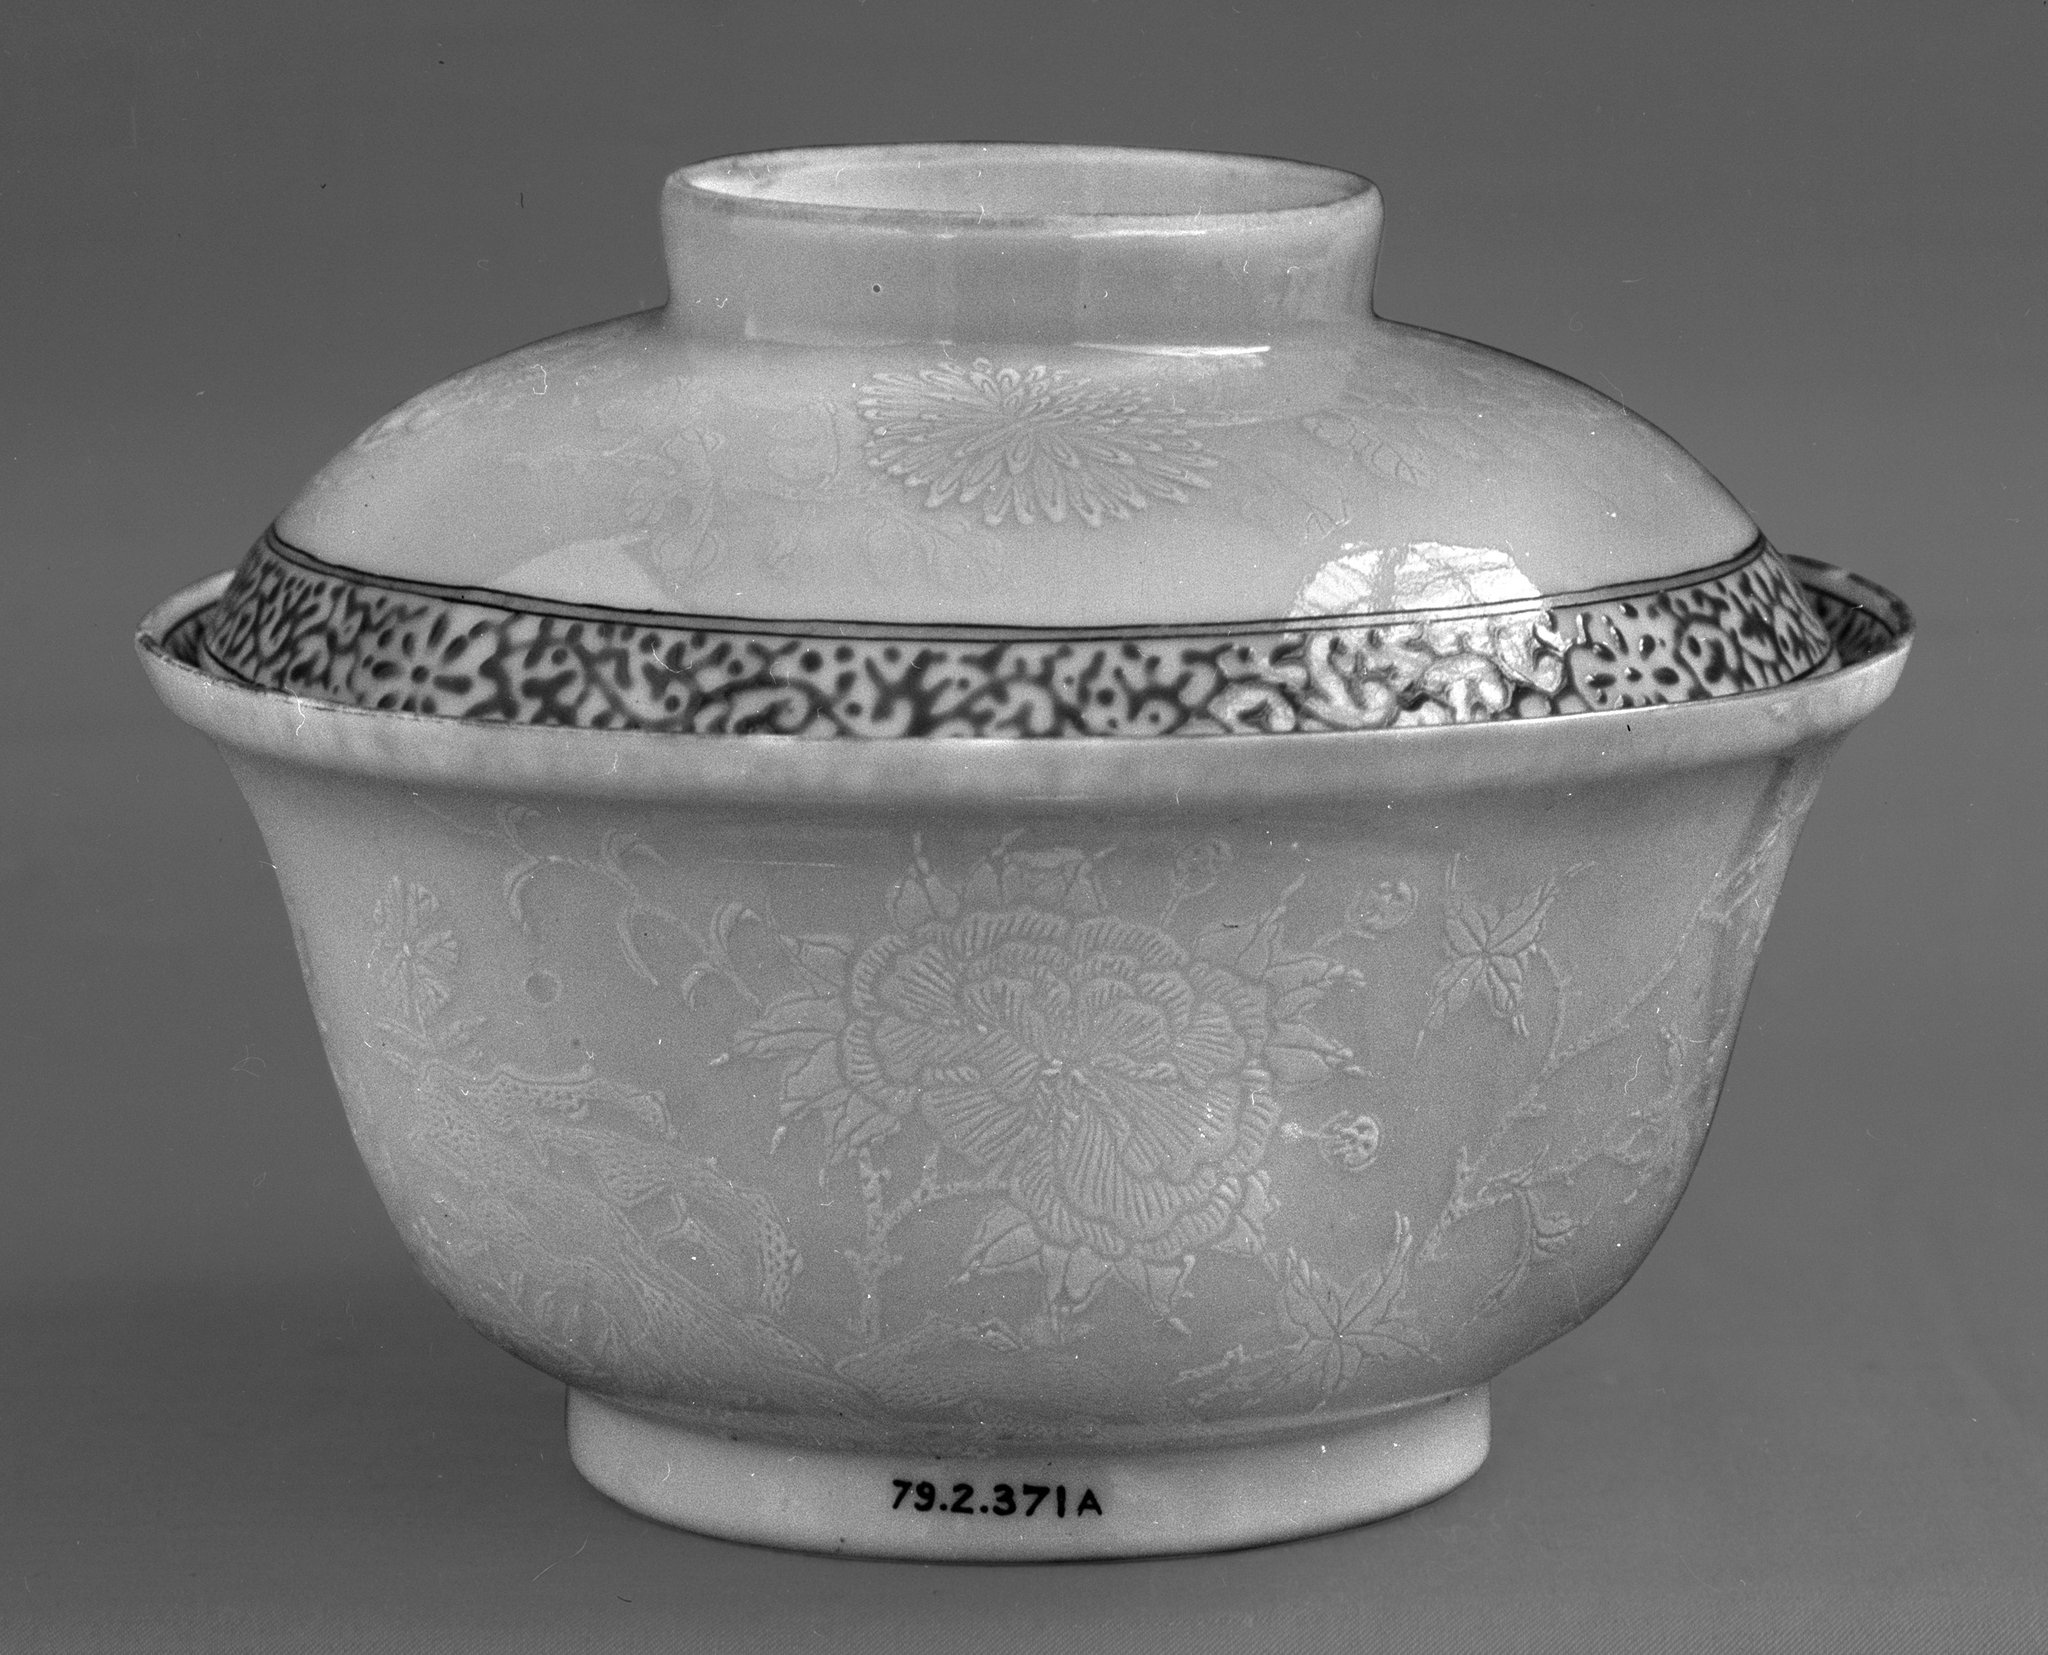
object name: covered cup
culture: chinese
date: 1767-1800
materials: enamel, porcelain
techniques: incising, overglaze, painting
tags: flowers